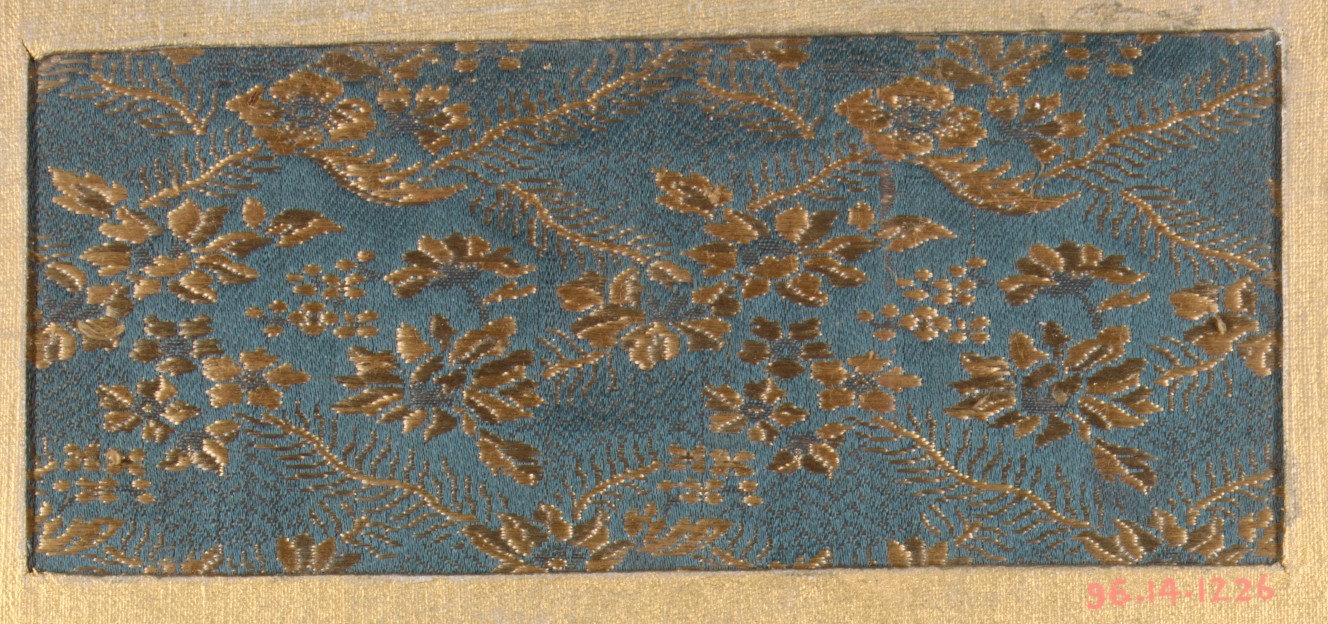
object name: piece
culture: japanese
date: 1701-1900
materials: silk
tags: flowers